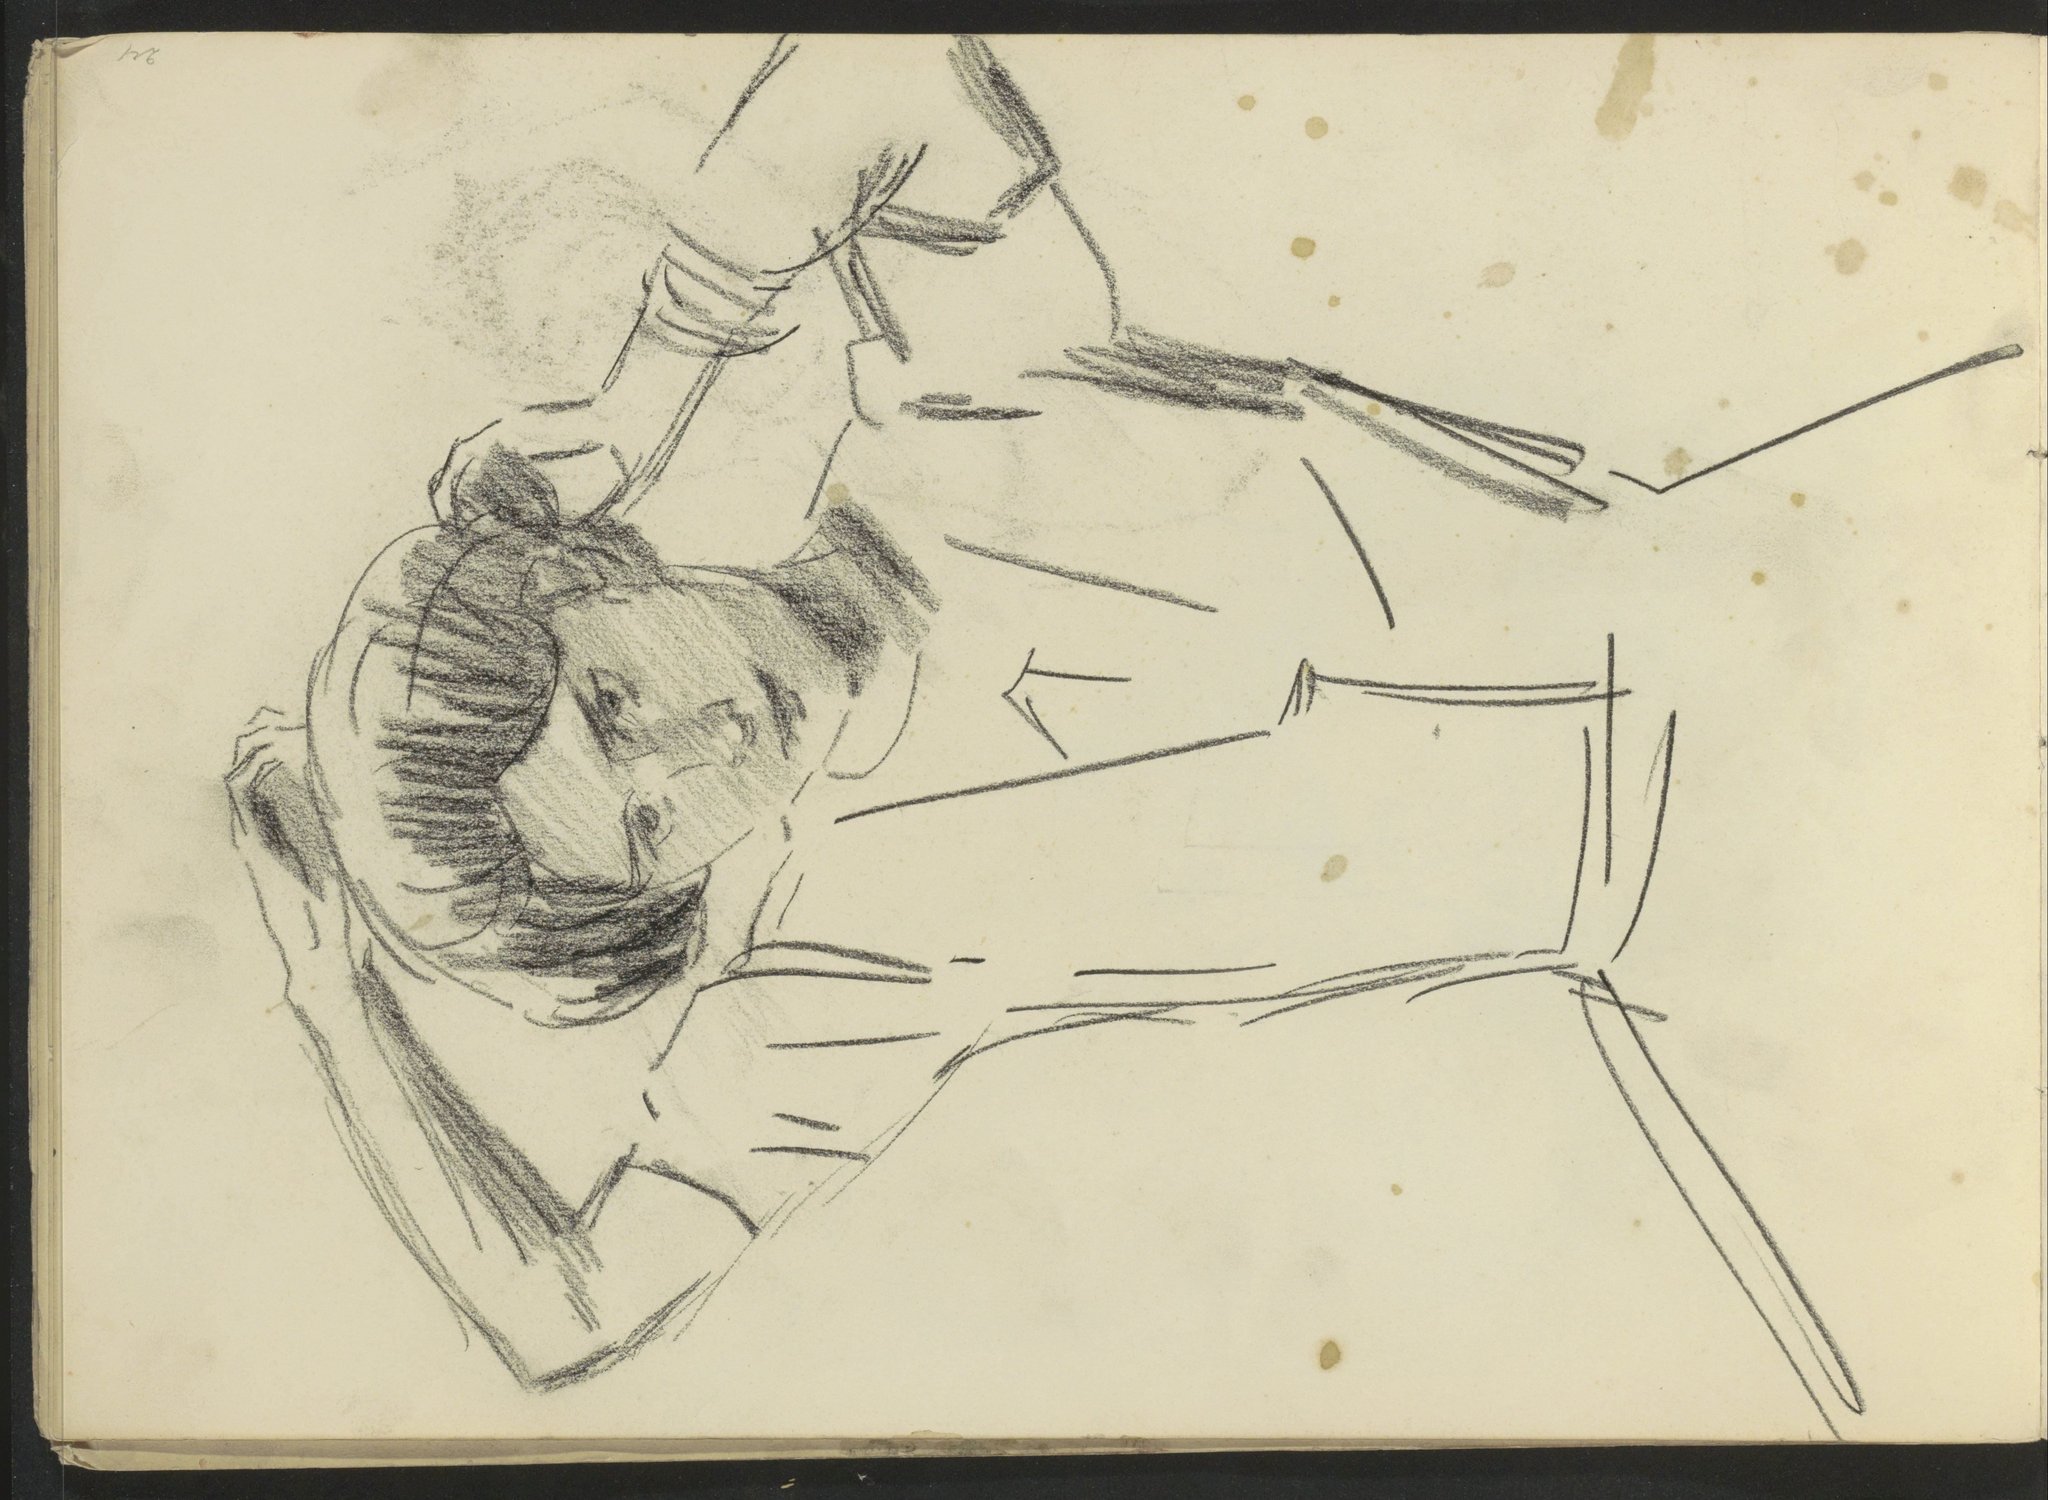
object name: sketchbook leaf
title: Vrouw die met haar kapsel bezig is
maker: isaac israels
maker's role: draughtsman, painter, print maker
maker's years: 1865-1934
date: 1875-1934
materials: chalk, paper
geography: the hague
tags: adult woman, hairdress - aa - ~ women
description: Blad 15 verso uit schetsboek XII met 19 bladen.